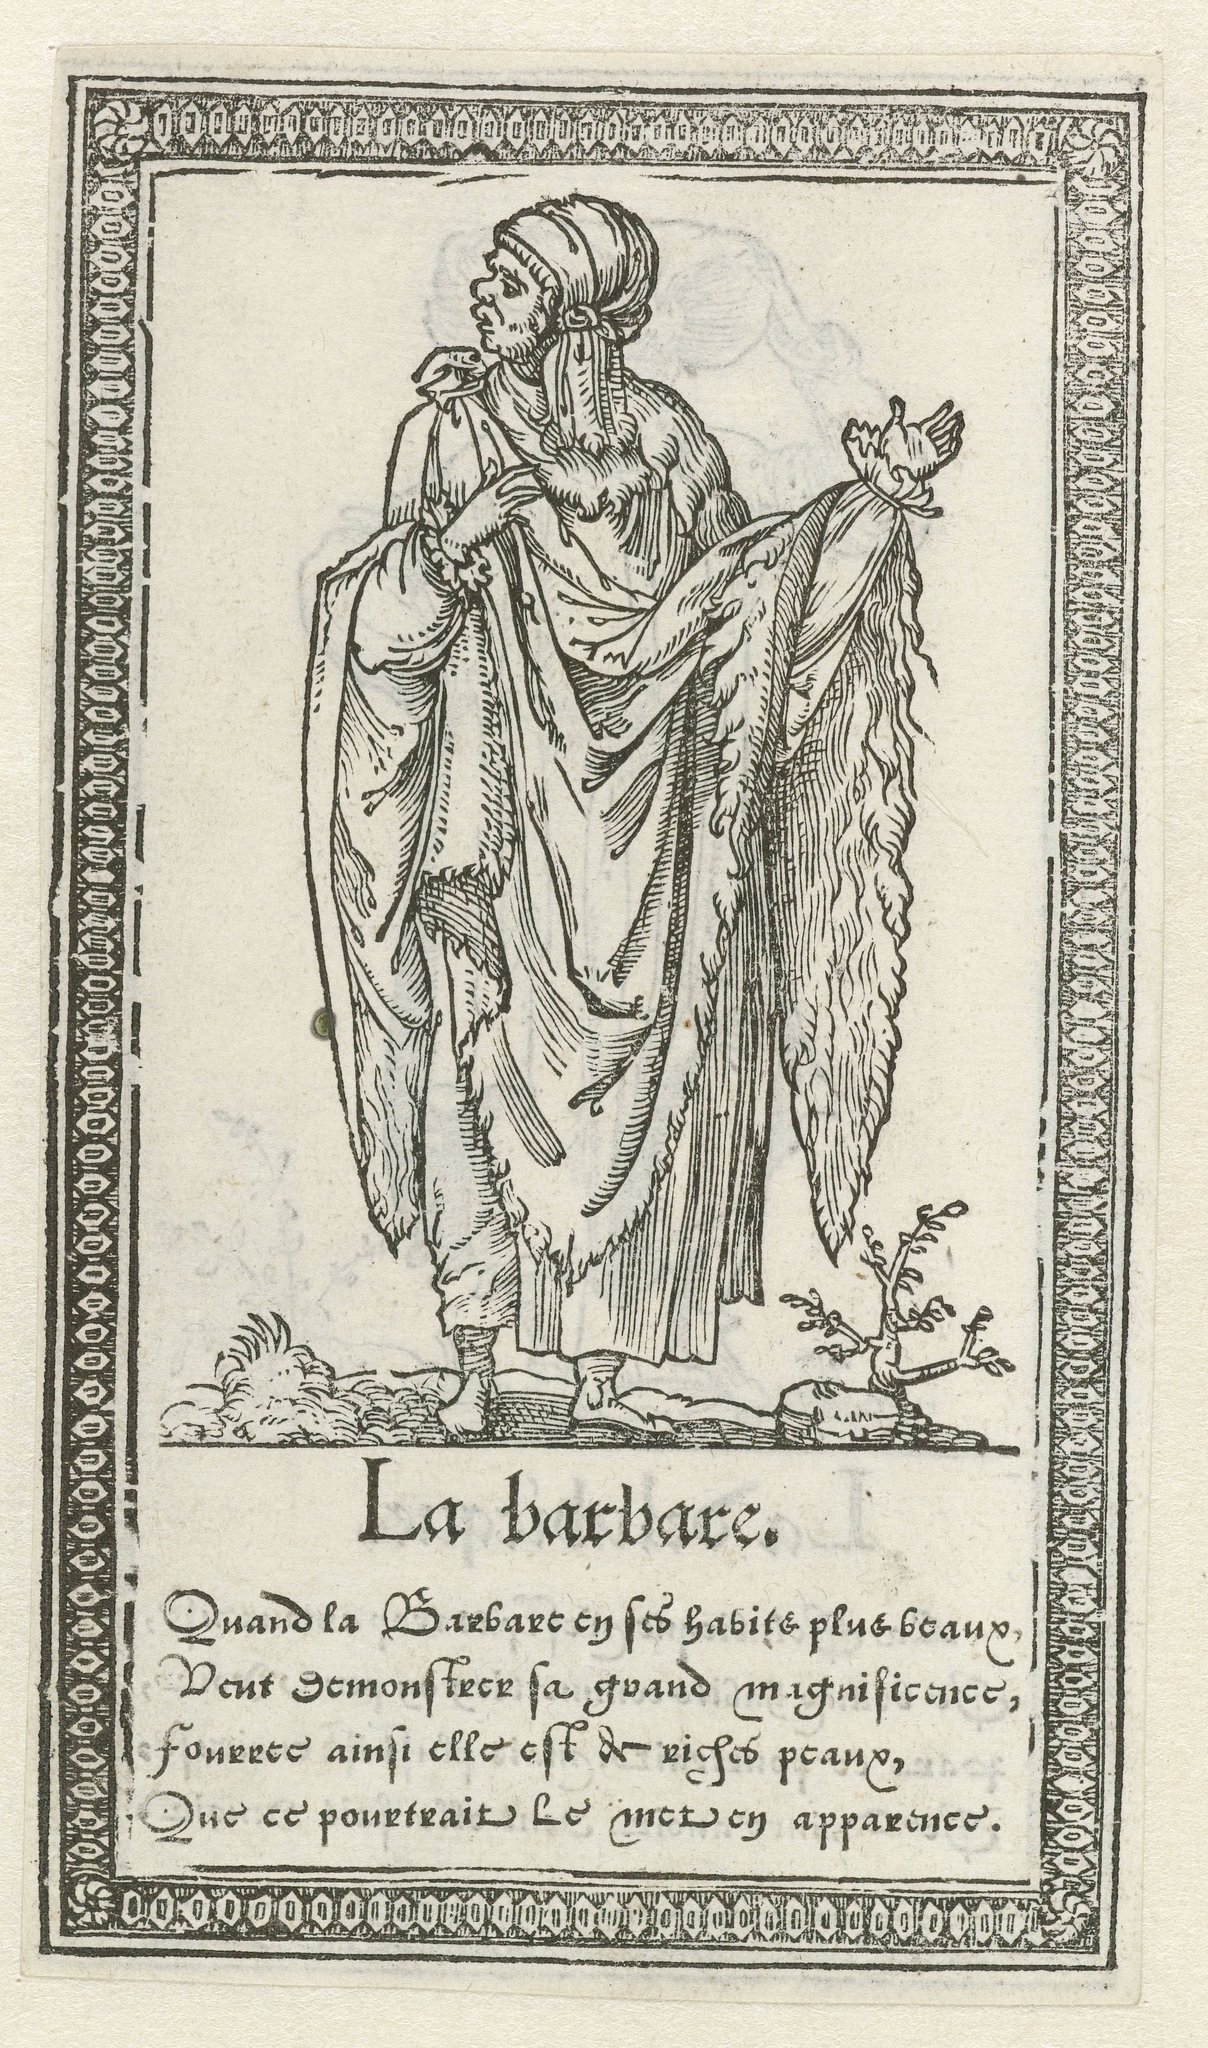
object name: print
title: Recueil de la diversité des habits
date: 1562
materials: paper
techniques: woodcut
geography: venice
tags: head-gear (with name), africans (with name), fashion plates, folk costume, regional costume, coat, cape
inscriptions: collector's mark: Lugt 2228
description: Dit is prent 88 uit een serie van 121. Binnen deze serie zijn er prenten gemaakt naar voorbeelden van Jean-François de Roberval en Enea Vico, onbekend welke precies.